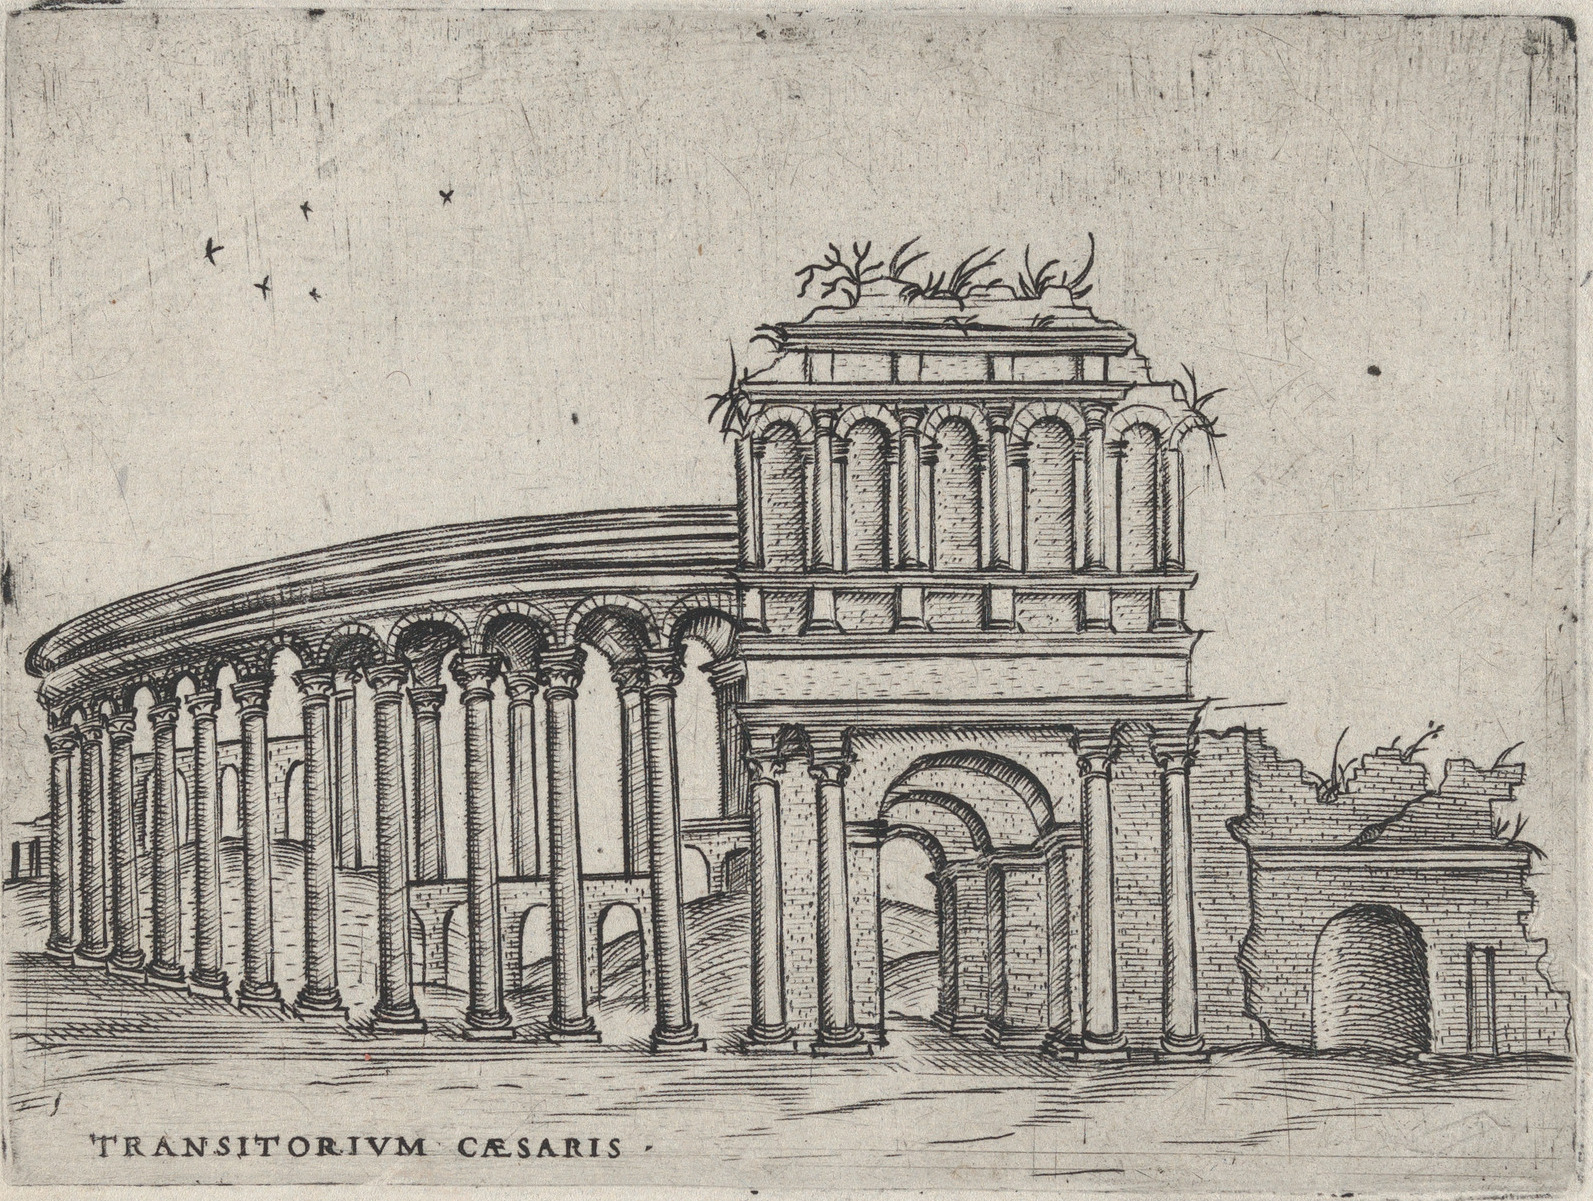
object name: print ornament architecture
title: Transitorium Caesaris [formerly Teatrum Bordeos], from a Series of 24 Depicting (Reconstructed) Buildings from Roman Antiquity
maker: anonymous, italian, 16th century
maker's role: artist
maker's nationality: italian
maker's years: 1500-1600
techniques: engraving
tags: architecture,buildings